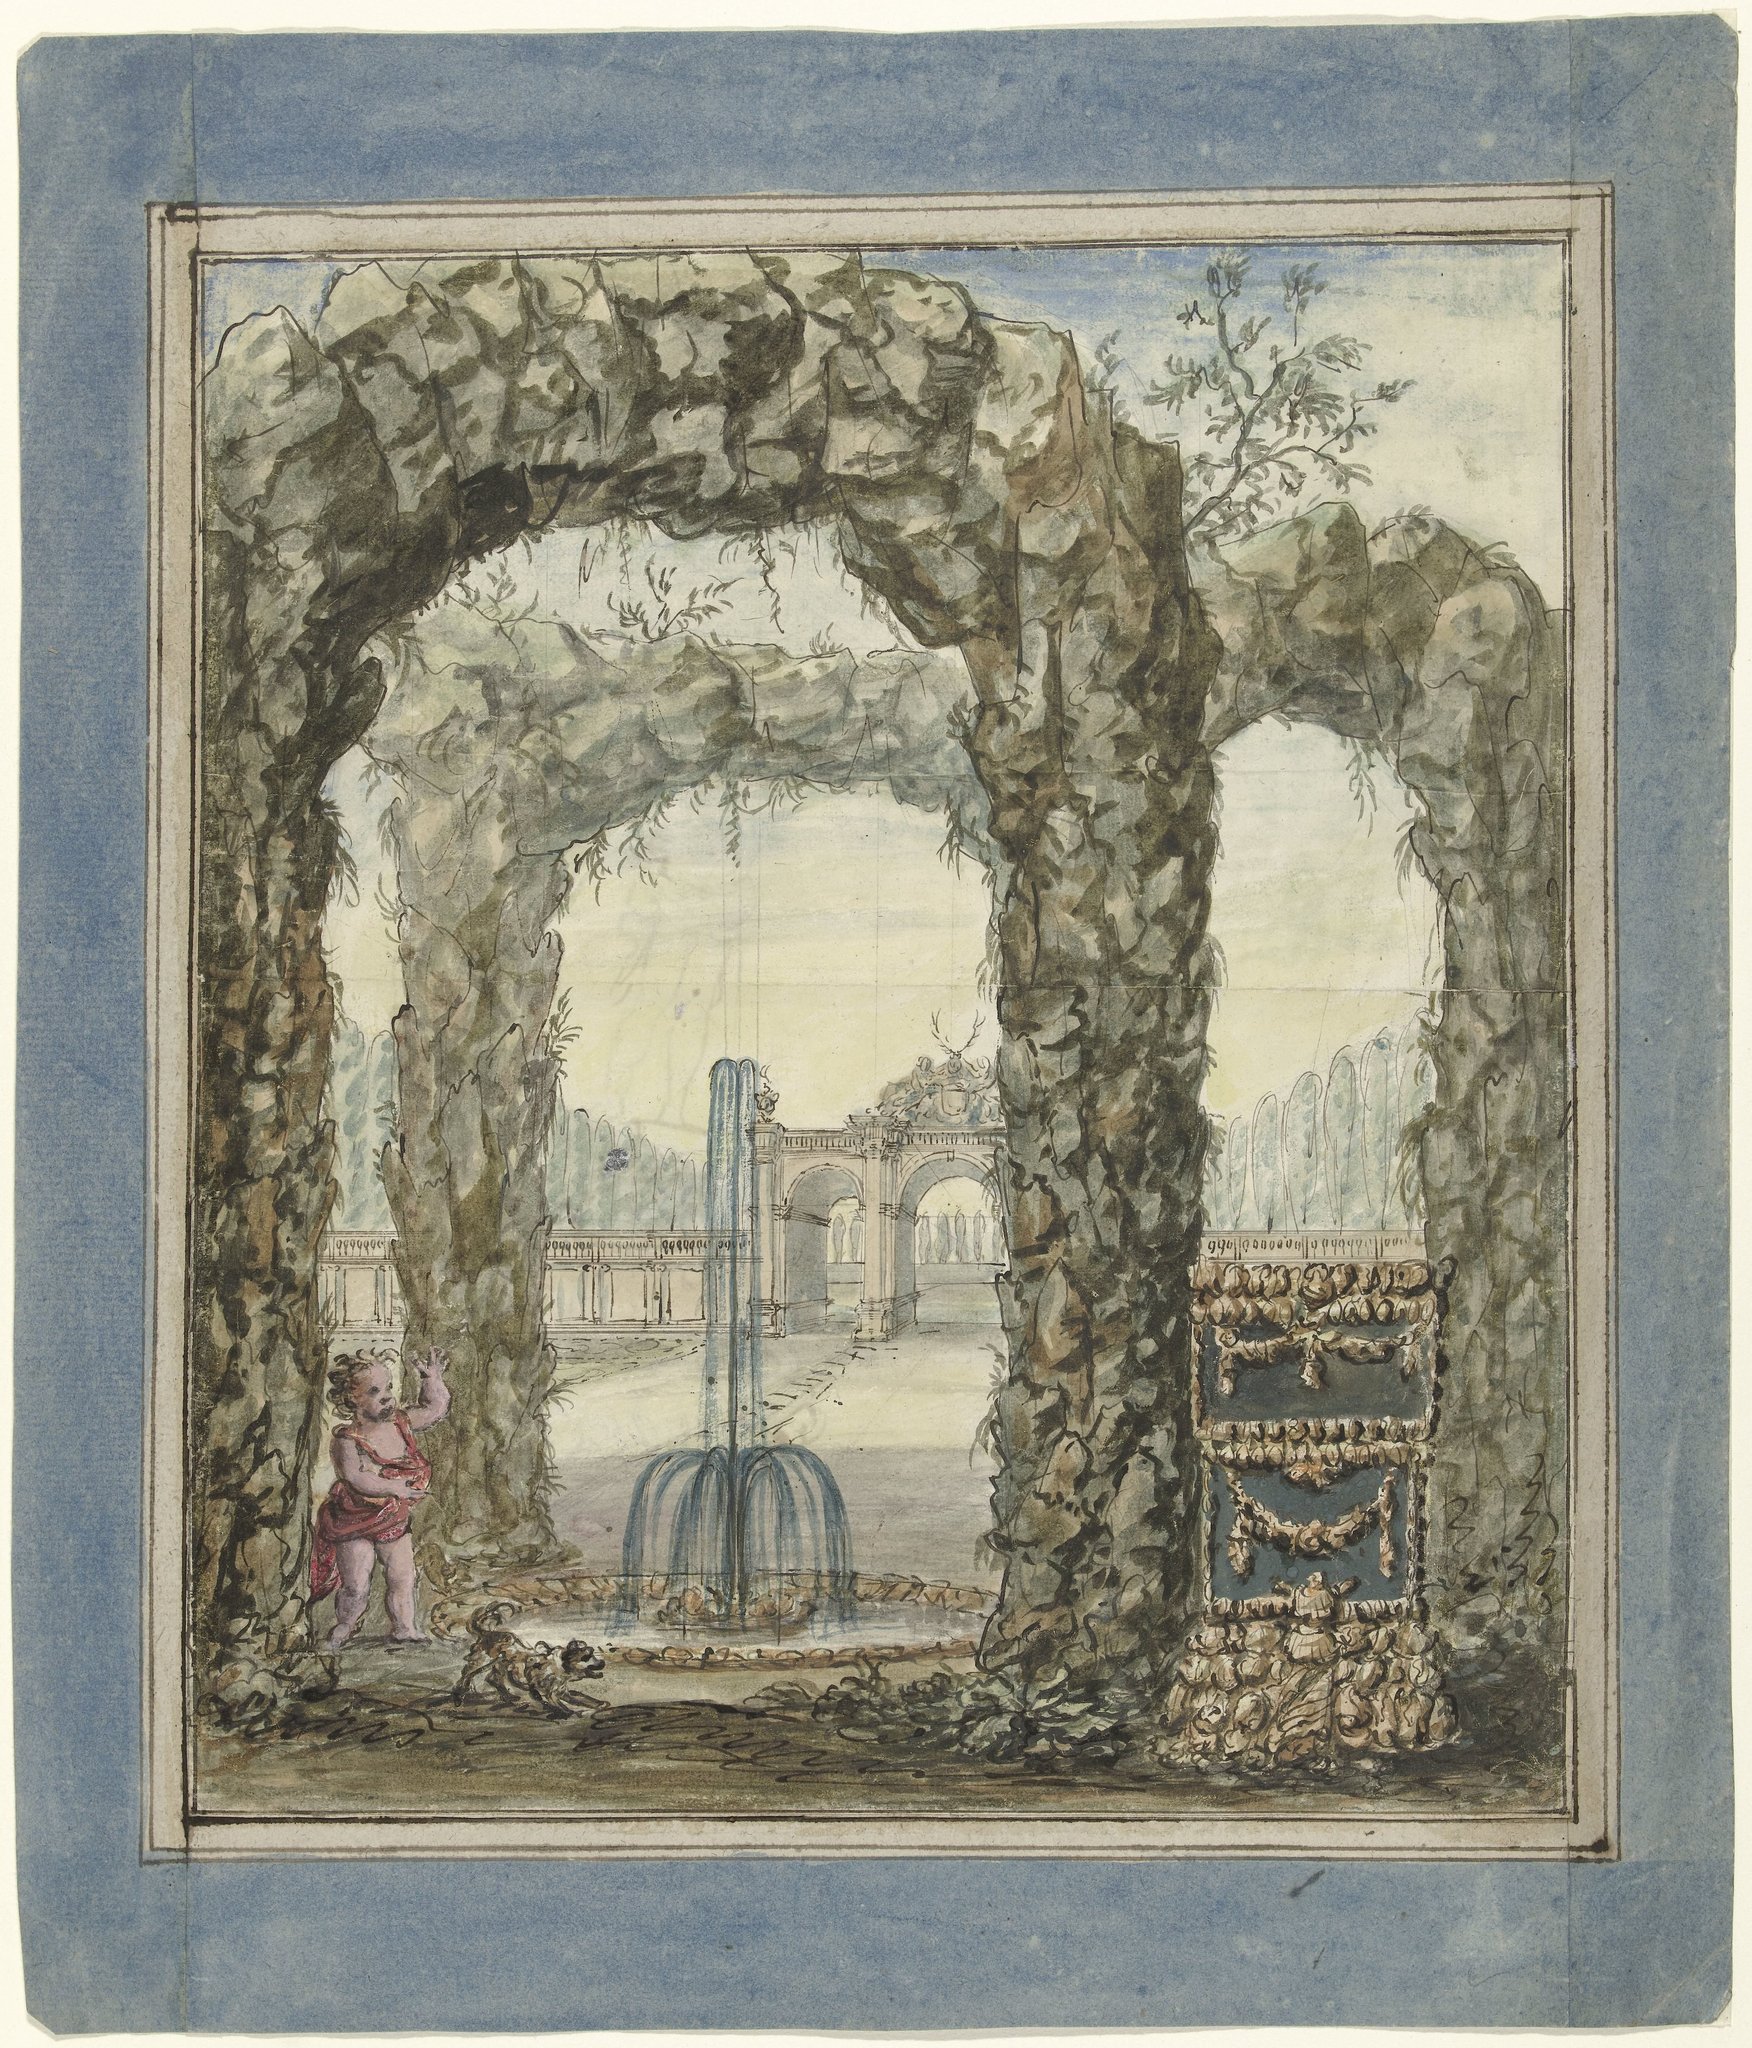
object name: watercolor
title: Ontwerp voor een kamerbeschildering met stenen bogen met een fontein en zicht op een tuin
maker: elias van nijmegen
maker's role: draughtsman, painter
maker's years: 1667-1755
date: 1677-1755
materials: ink, paper, pencil, watercolor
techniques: brush, pen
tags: garden fountain, garden ornaments